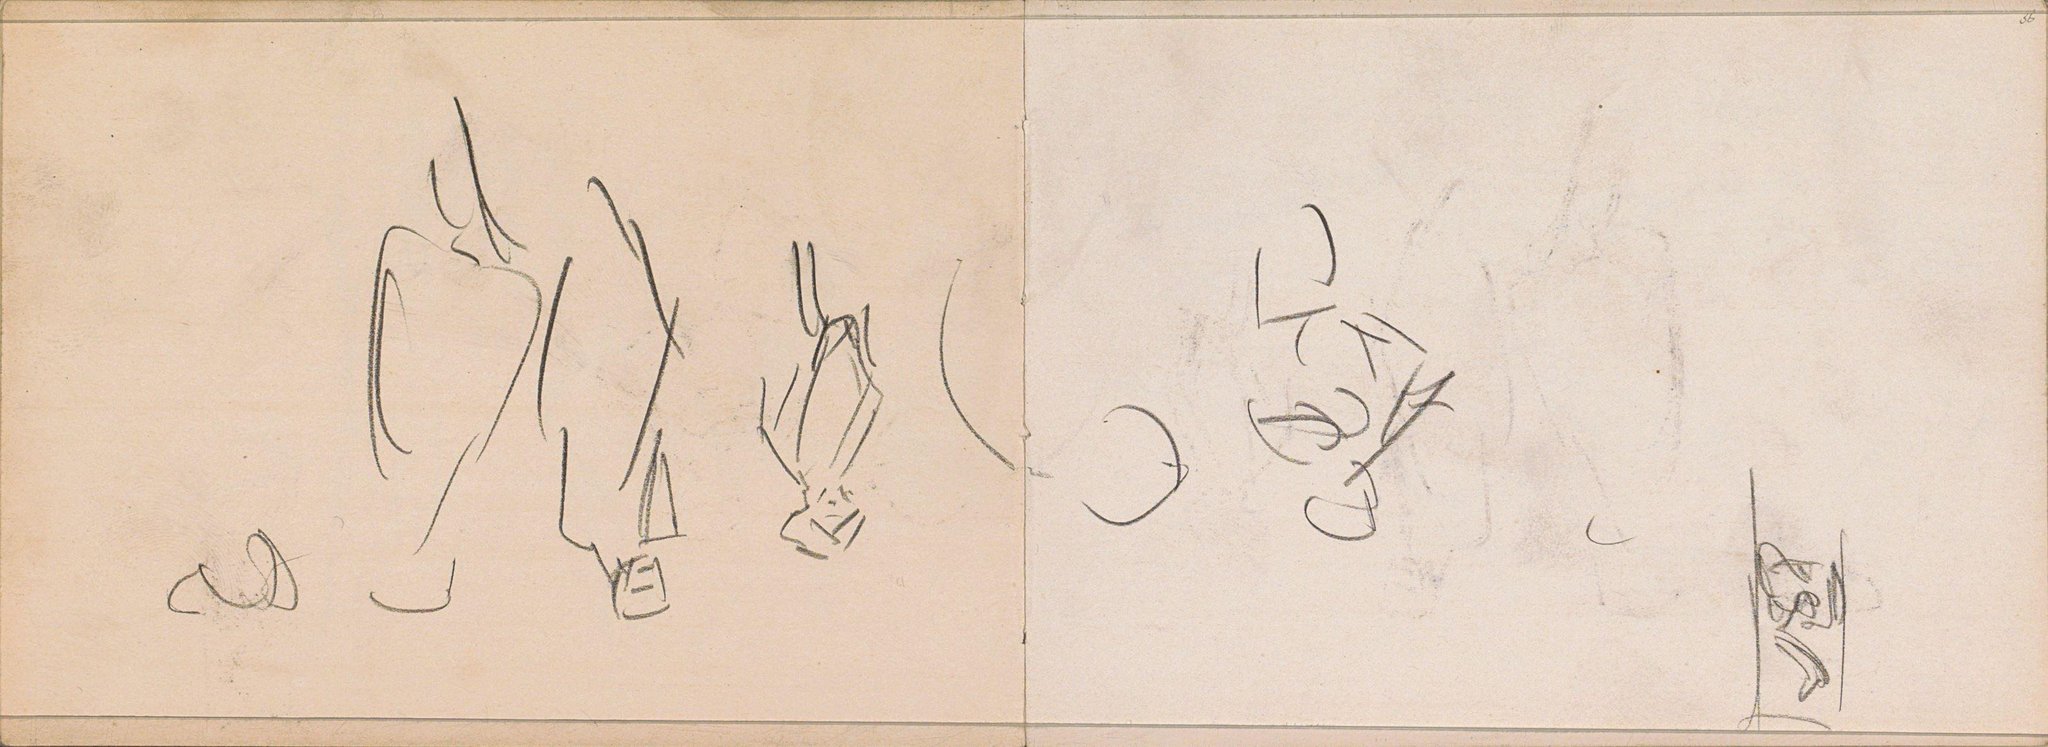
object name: sketchbook leaf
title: Staande figuren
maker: isaac israels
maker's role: draughtsman, painter, print maker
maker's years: 1865-1934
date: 1875-1934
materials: chalk, paper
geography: paris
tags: the (nude) human figure; 'corpo humano' (ripa) (+ standing)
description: Pagina 35 en pagina 36 uit schetsboek XLV met 85 pagina's.